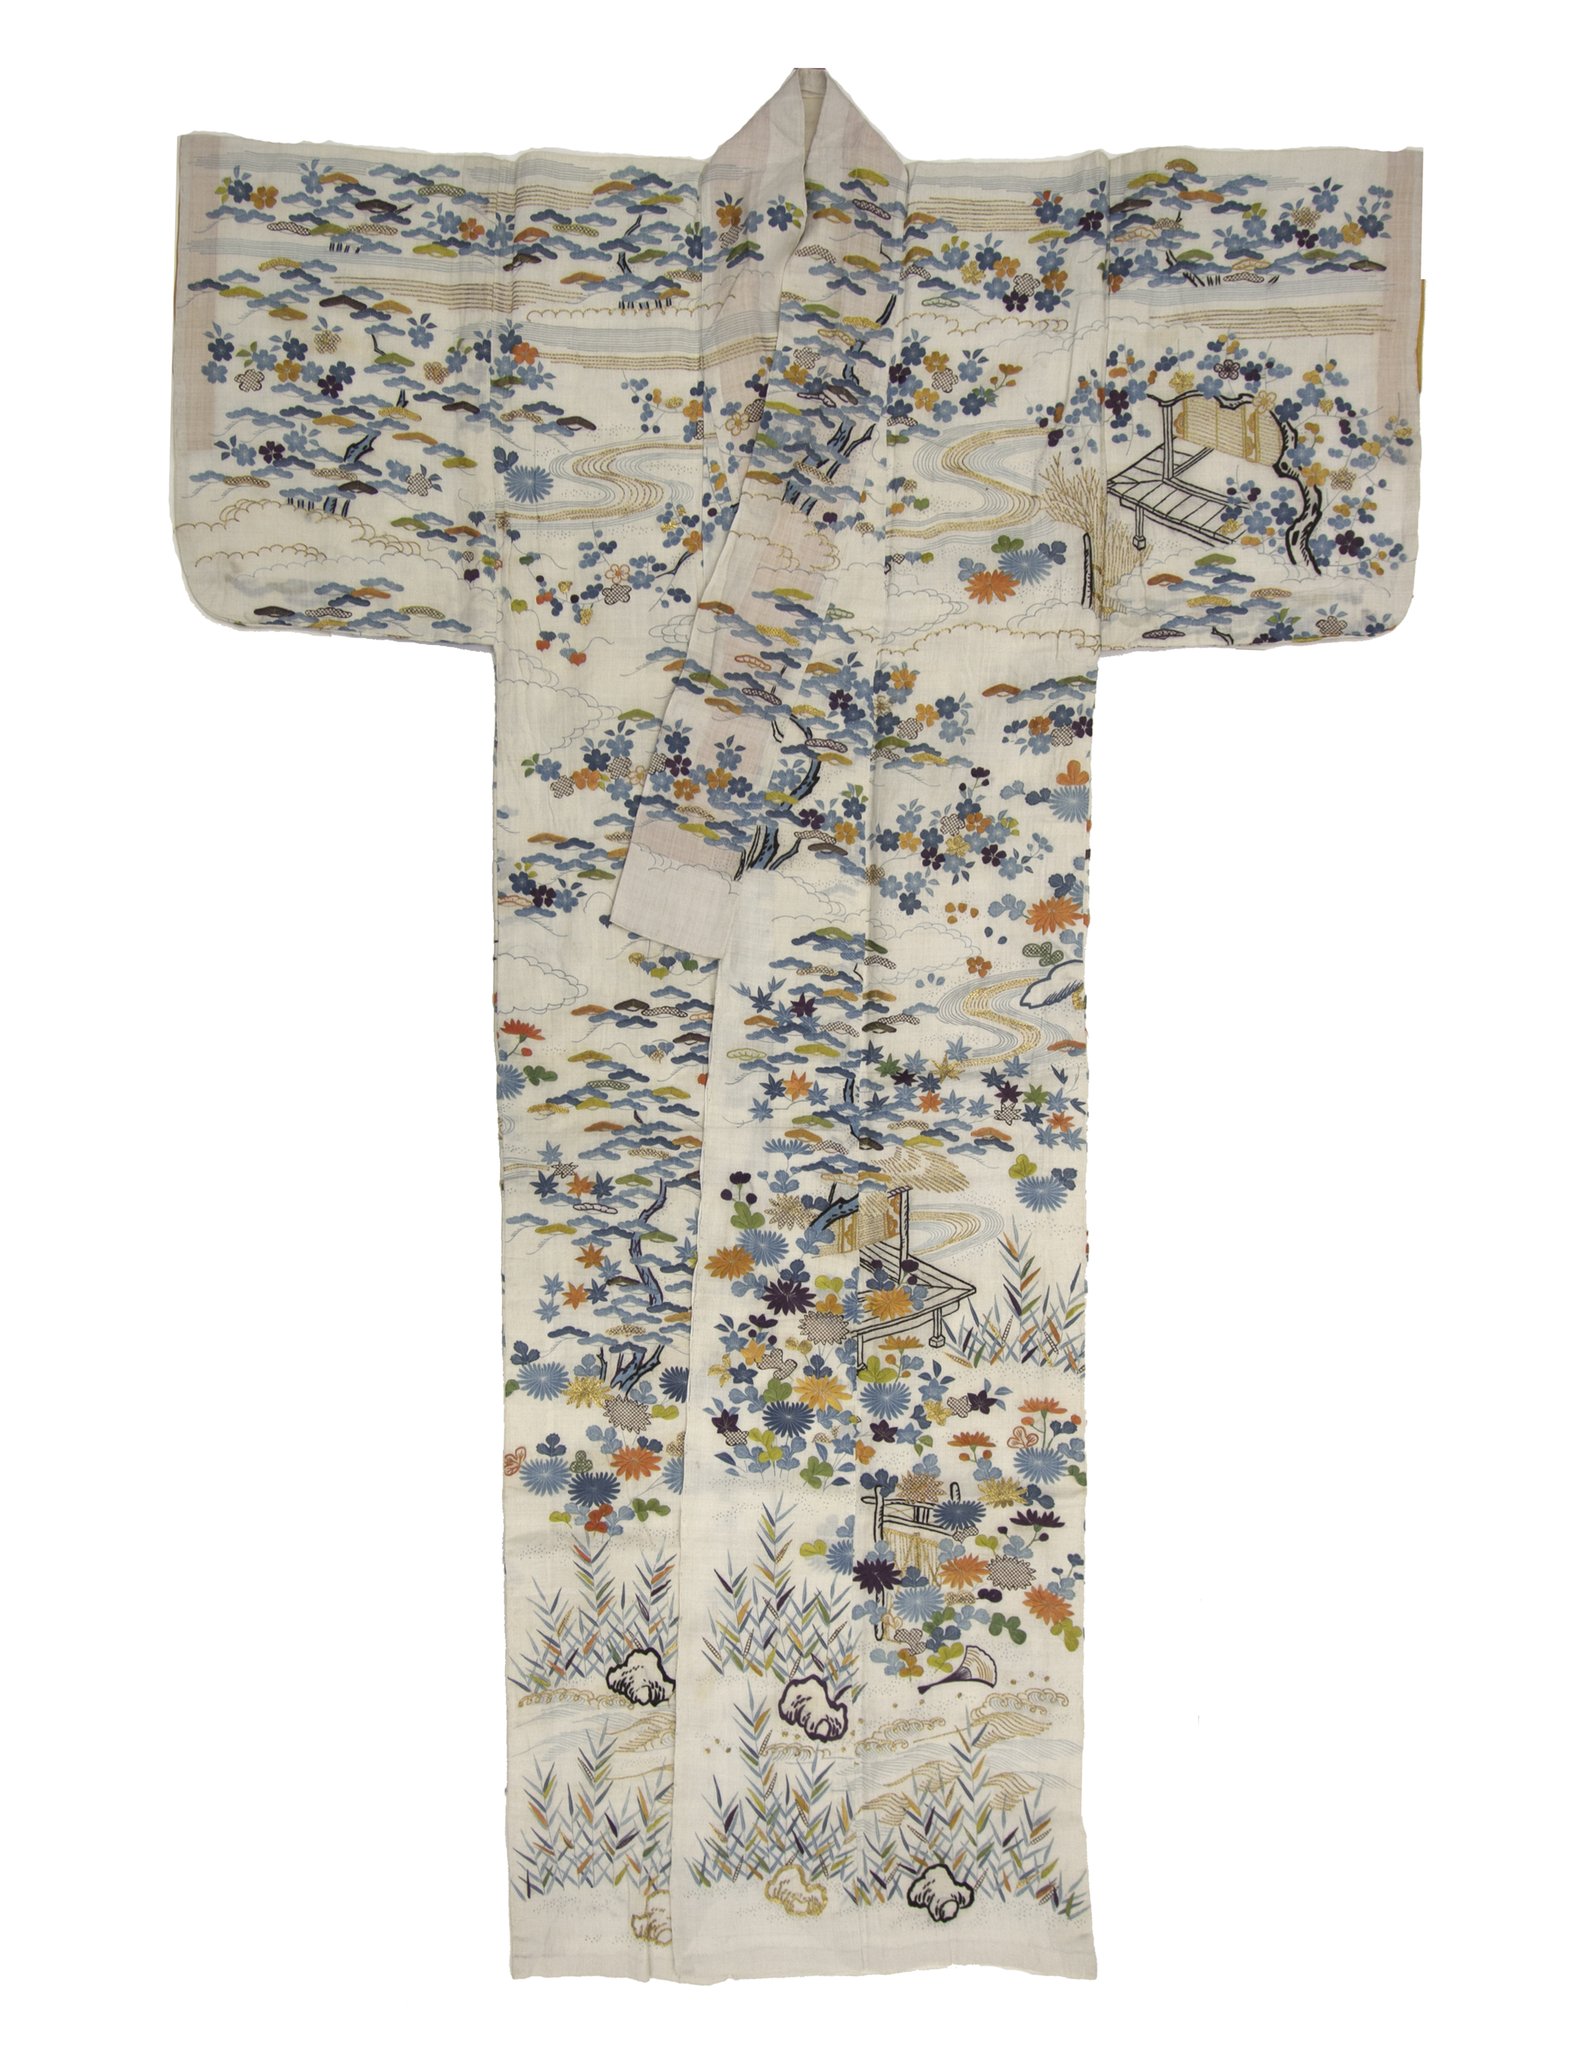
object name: robe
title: Summer Robe (Katabira) with Seasonal Landscapes and Scenes from The Tale of Genji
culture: japanese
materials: gold thread, paste, thread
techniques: embroidery, weave, resist